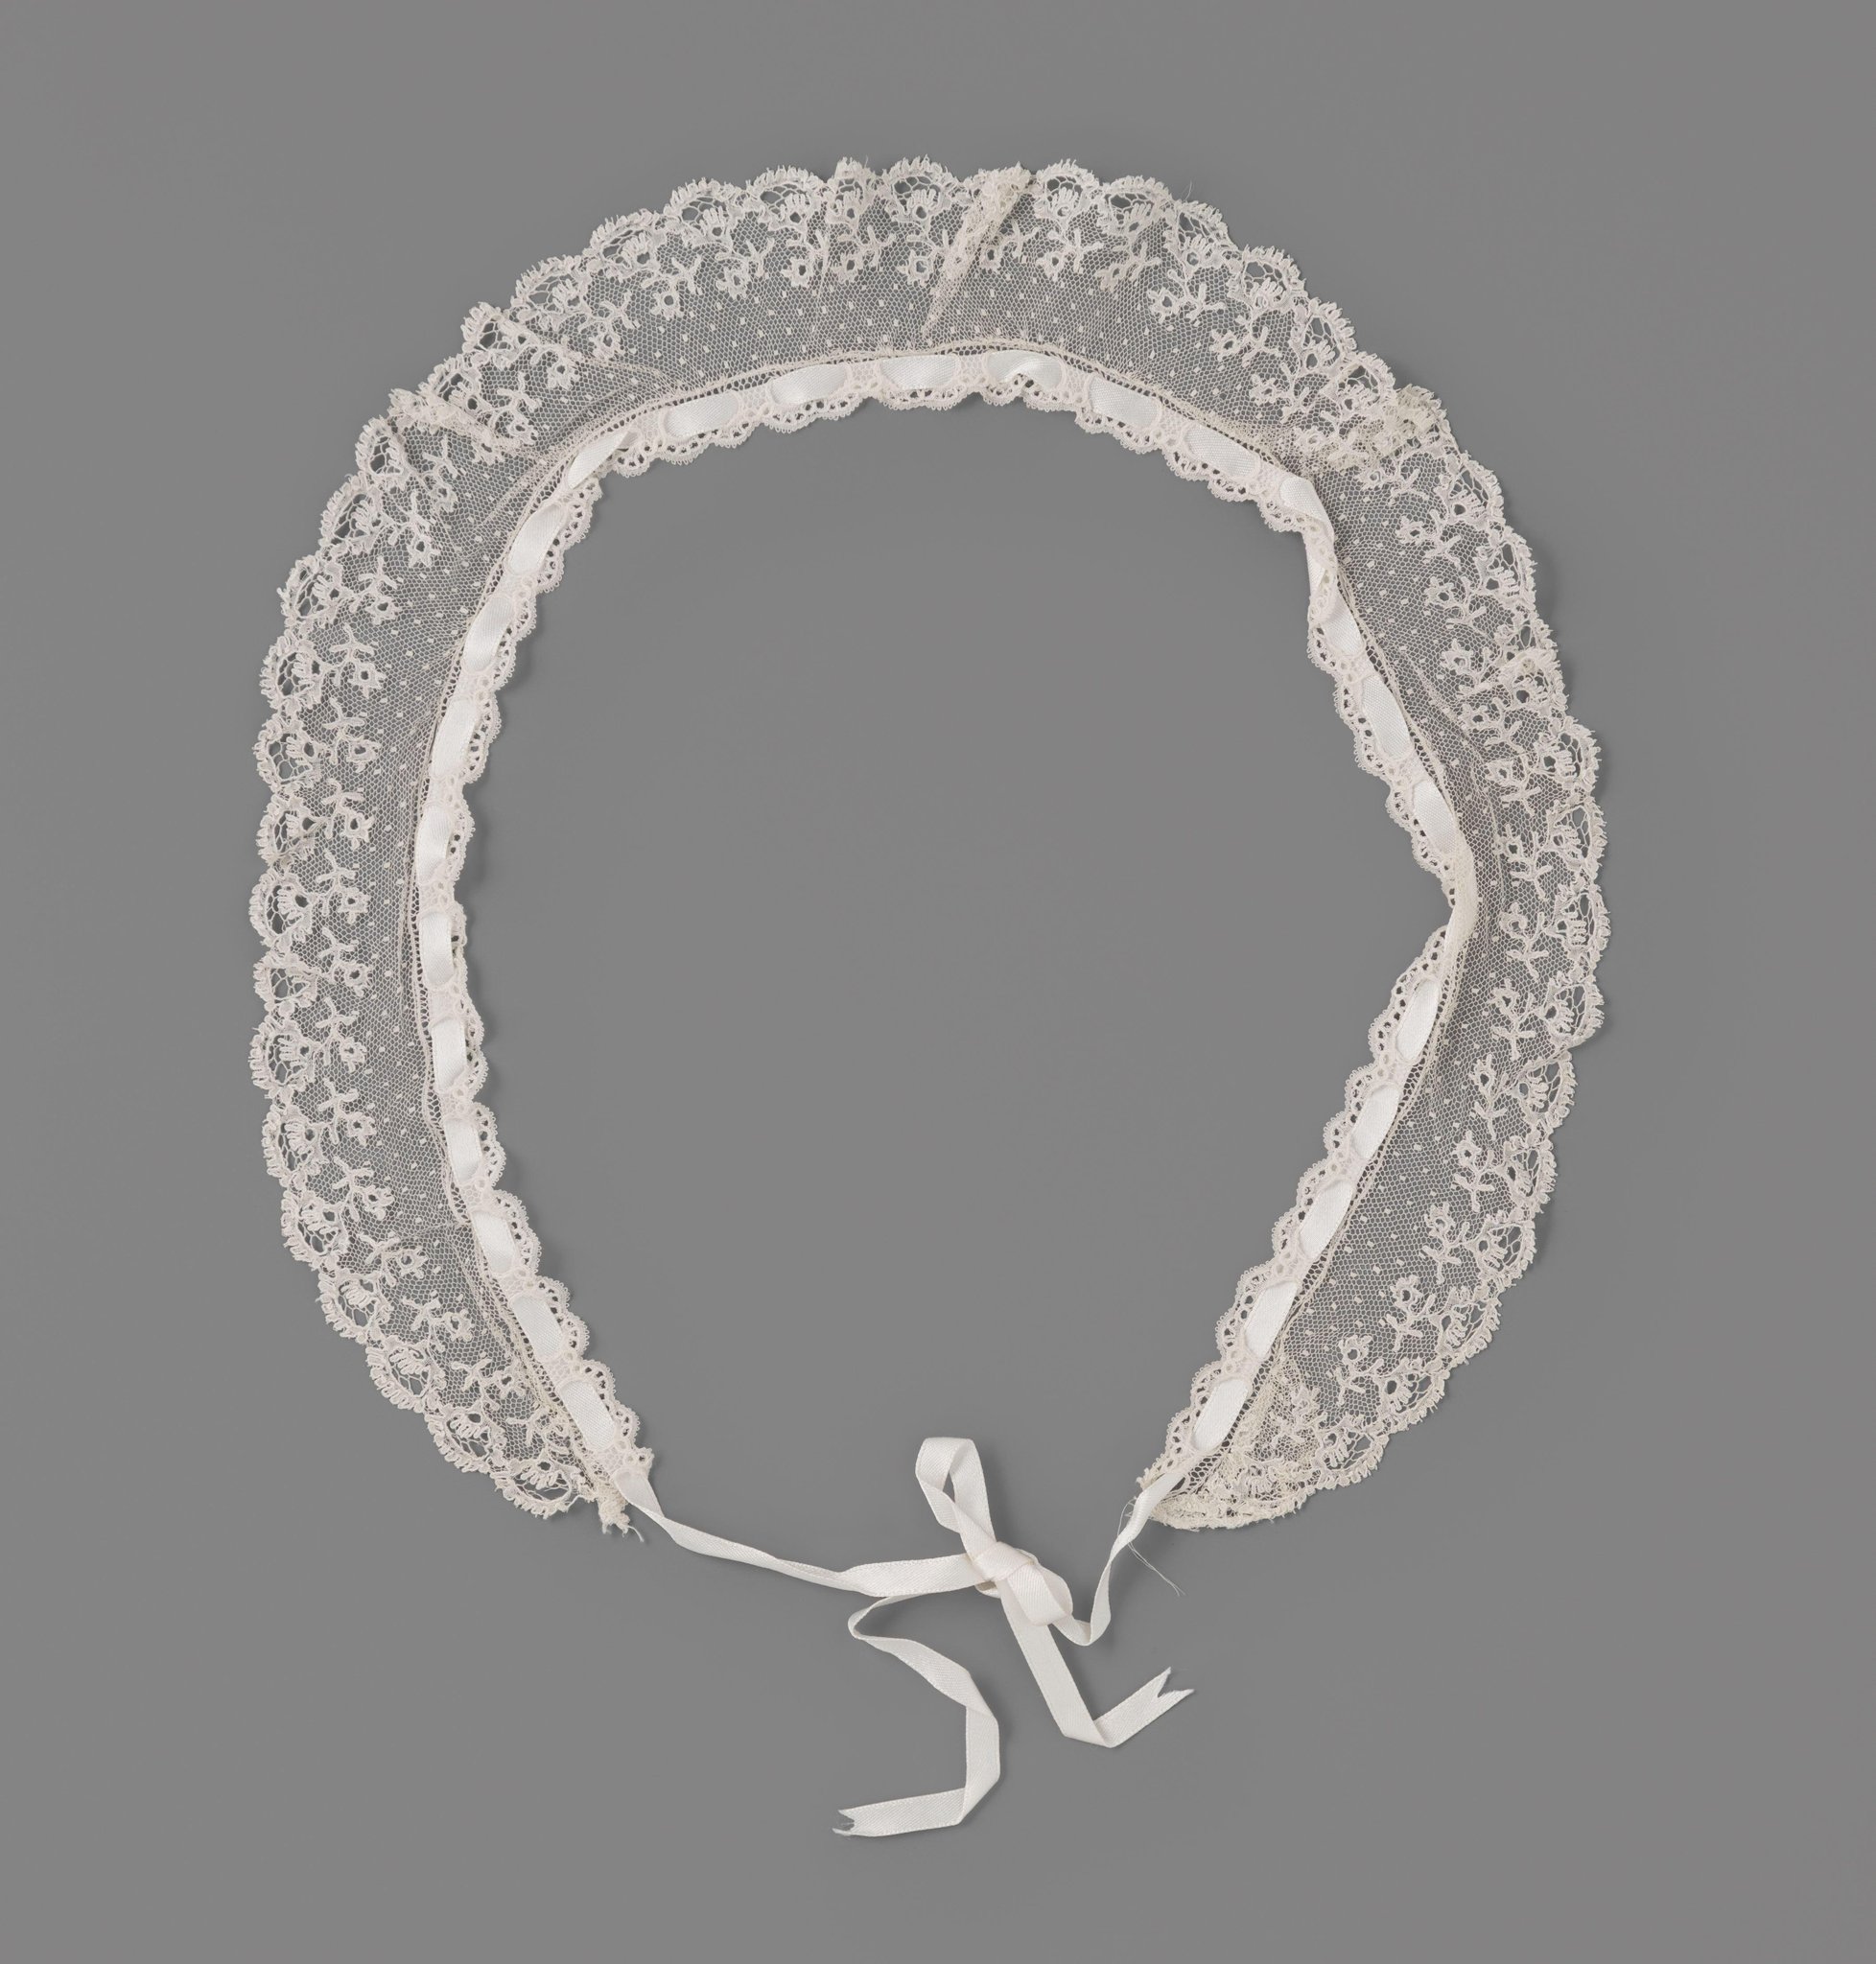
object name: collar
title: Kraag van Rijsselse kant, rond model met wit lint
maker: Anonymous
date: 1870-1875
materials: lace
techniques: lace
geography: western europe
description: Kraag van Rijsselse kant, rond model met wit lint. Smal berthe-model, met staande smalle strook kant en een brede hangende strook kant. In de staande strook zijn gaten aangebracht waardoorheen een wit lint is geregen. De hangende strook is bezaaid met moesjes en de gepicoteerde schulpen zijn versierd met kelkbloemen aan een tak.